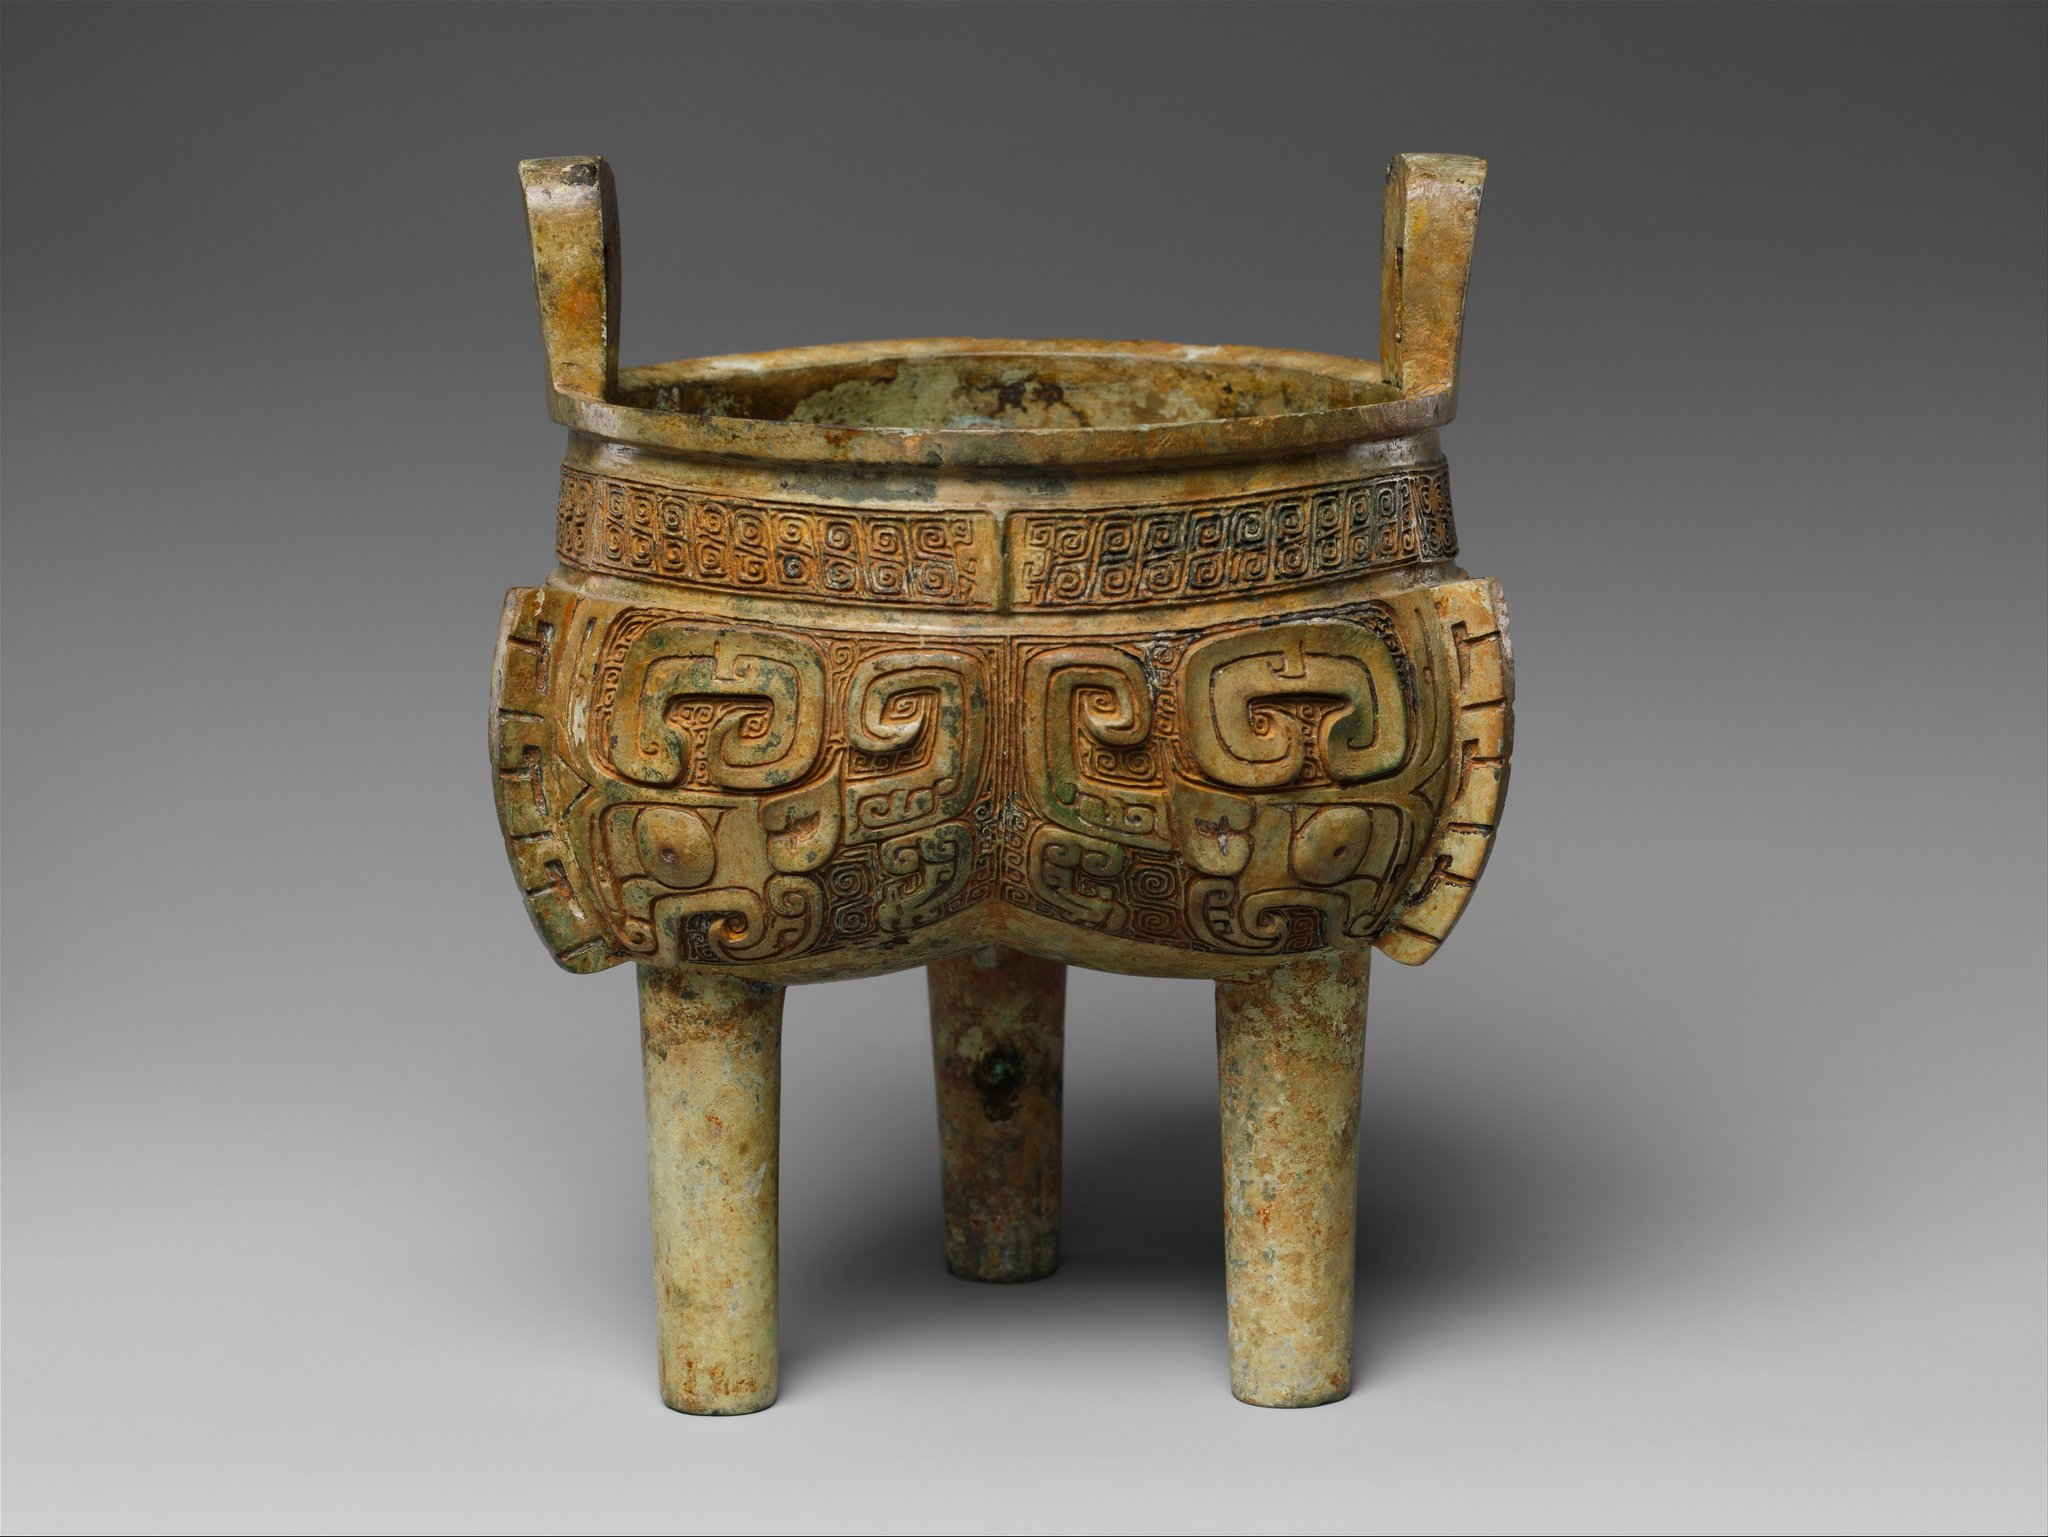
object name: cauldron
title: Lobed Tripod Cauldron (Liding)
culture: chinese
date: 1200-1001 BCE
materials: bronze